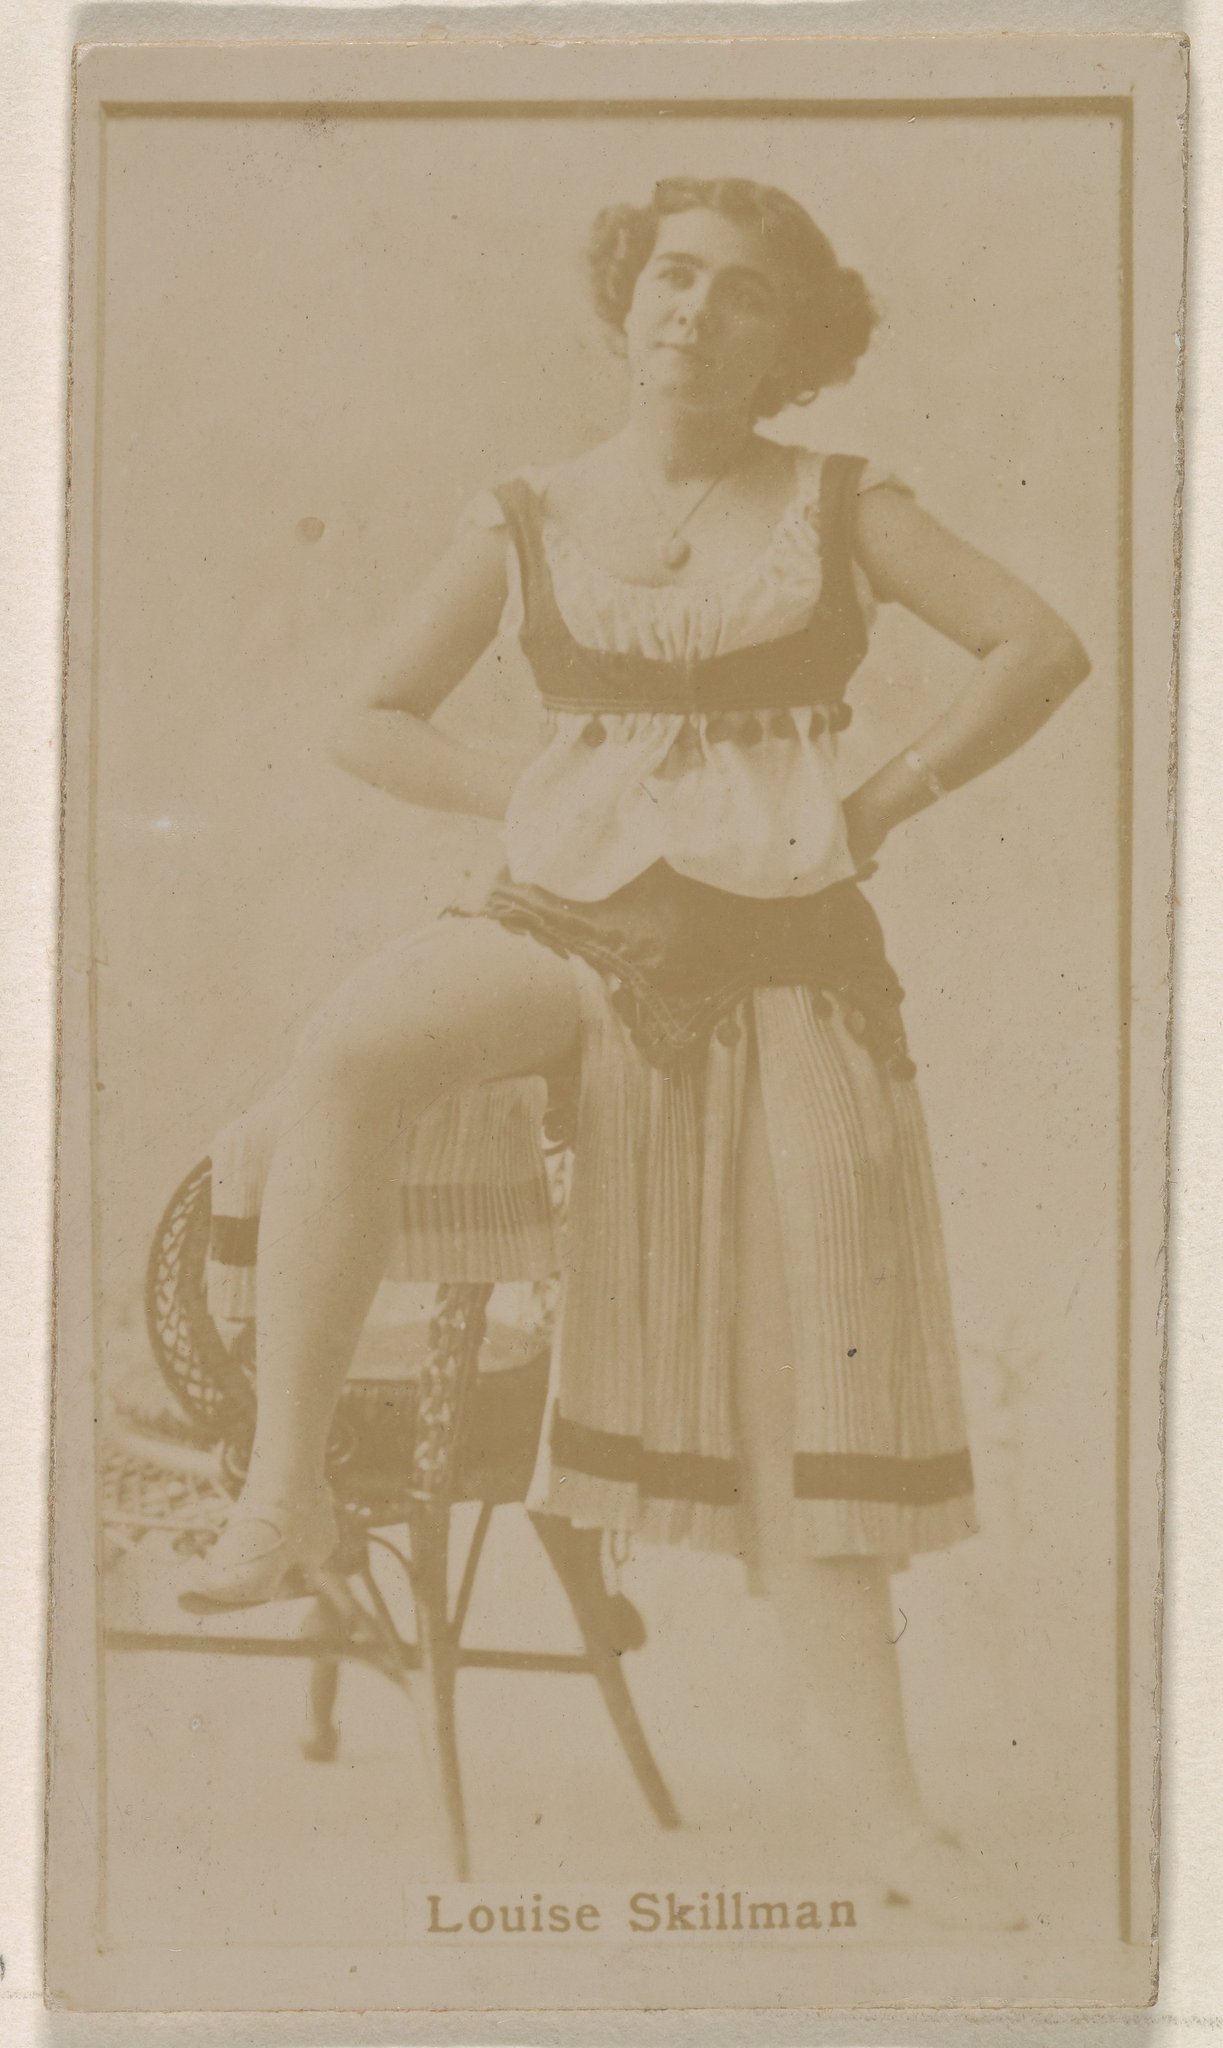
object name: photograph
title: Louise Skillman, from the Actresses series (N245) issued by Kinney Brothers to promote Sweet Caporal Cigarettes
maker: kinney brothers tobacco company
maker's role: publisher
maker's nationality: american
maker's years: 1869-2011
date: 1890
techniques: albumen silver print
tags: portraits,women,actresses